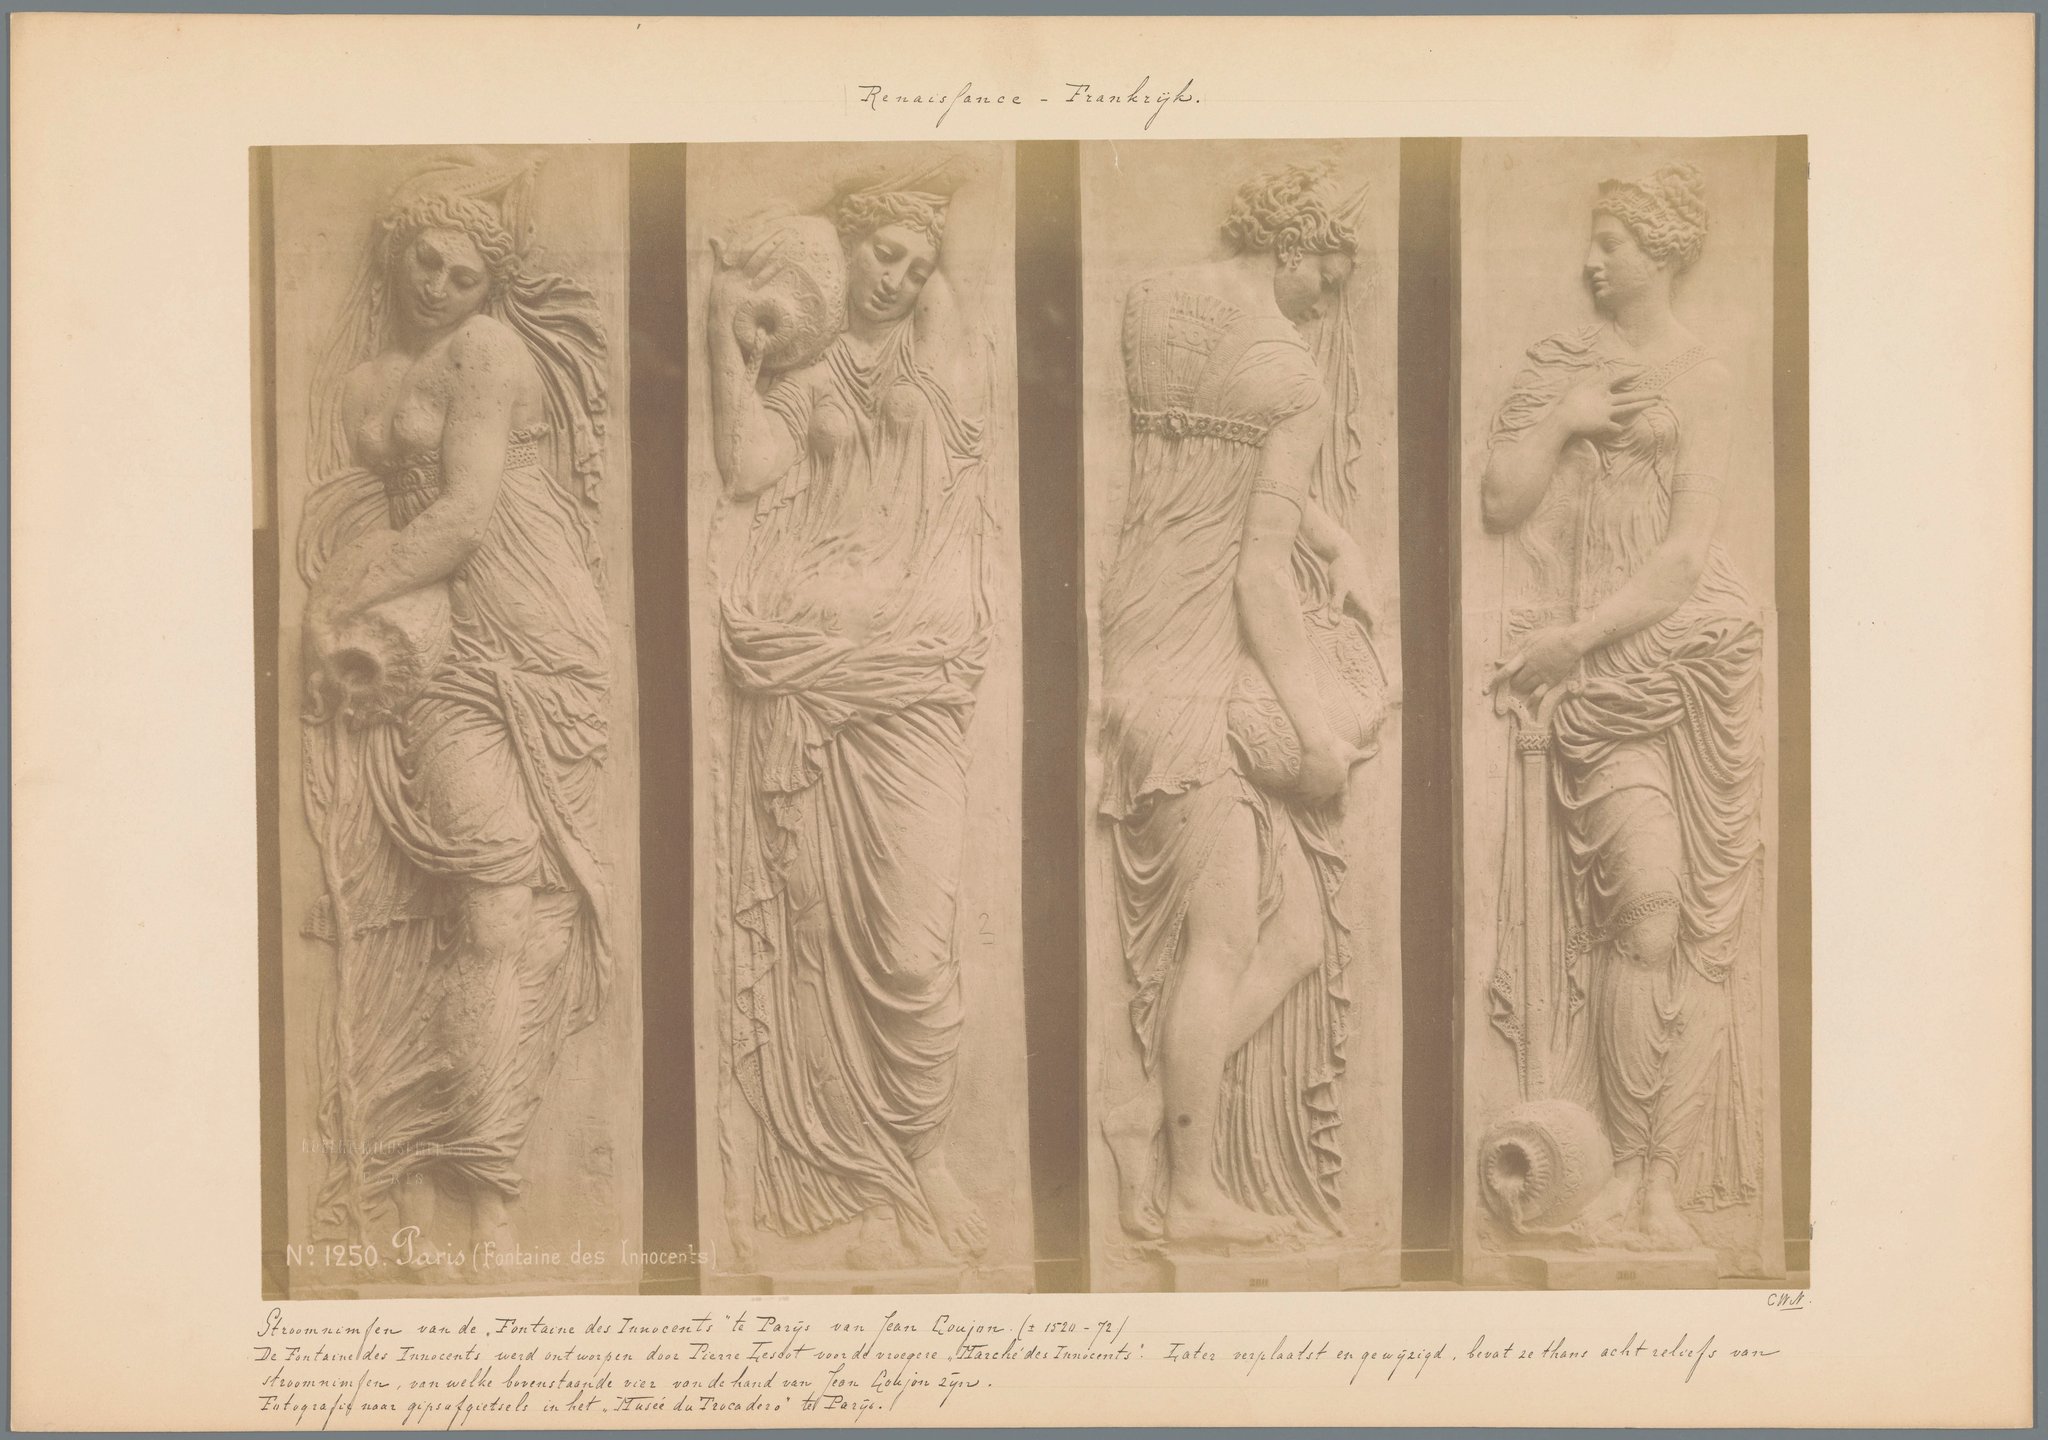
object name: photograph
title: Paris (Fontaine des Innocents)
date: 1875-1900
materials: cardboard, photographic support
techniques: albumen print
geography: paris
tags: adult woman, jar, jug (used as drinking-vessel), ornamental fountain, sculpture (+ relief ~ sculpture)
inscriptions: inscription: ‘Renaissance - Frankrijk. Stroomnimfen van de ,,Fontaine des Innocents'' te Parijs van Jean Goujon (+- 1520-72) (...) Fotografie naar gipsafgietsels in het ,,Musée du Trocadero'' te Parijs.’, collector's mark: ‘INSTITUUT VOOR KUNST- NIJVERHEIDSONDERWIJS GABRIËL METSUSTRAAT No. 16. AMSTERDAM’, number: ‘No. 1250.’, collector's mark: ‘KUNSTNIJVERHEIDSCHOOL QUELLINUS AMSTERDAM FRANS HALSSTRAAT 14.’, name: ‘ROBERT-MIEUSEMENT.EDIT. PARIS’, inscription: ‘CWN.’, inscription: ‘MONUMENTS HISTORIQUES’